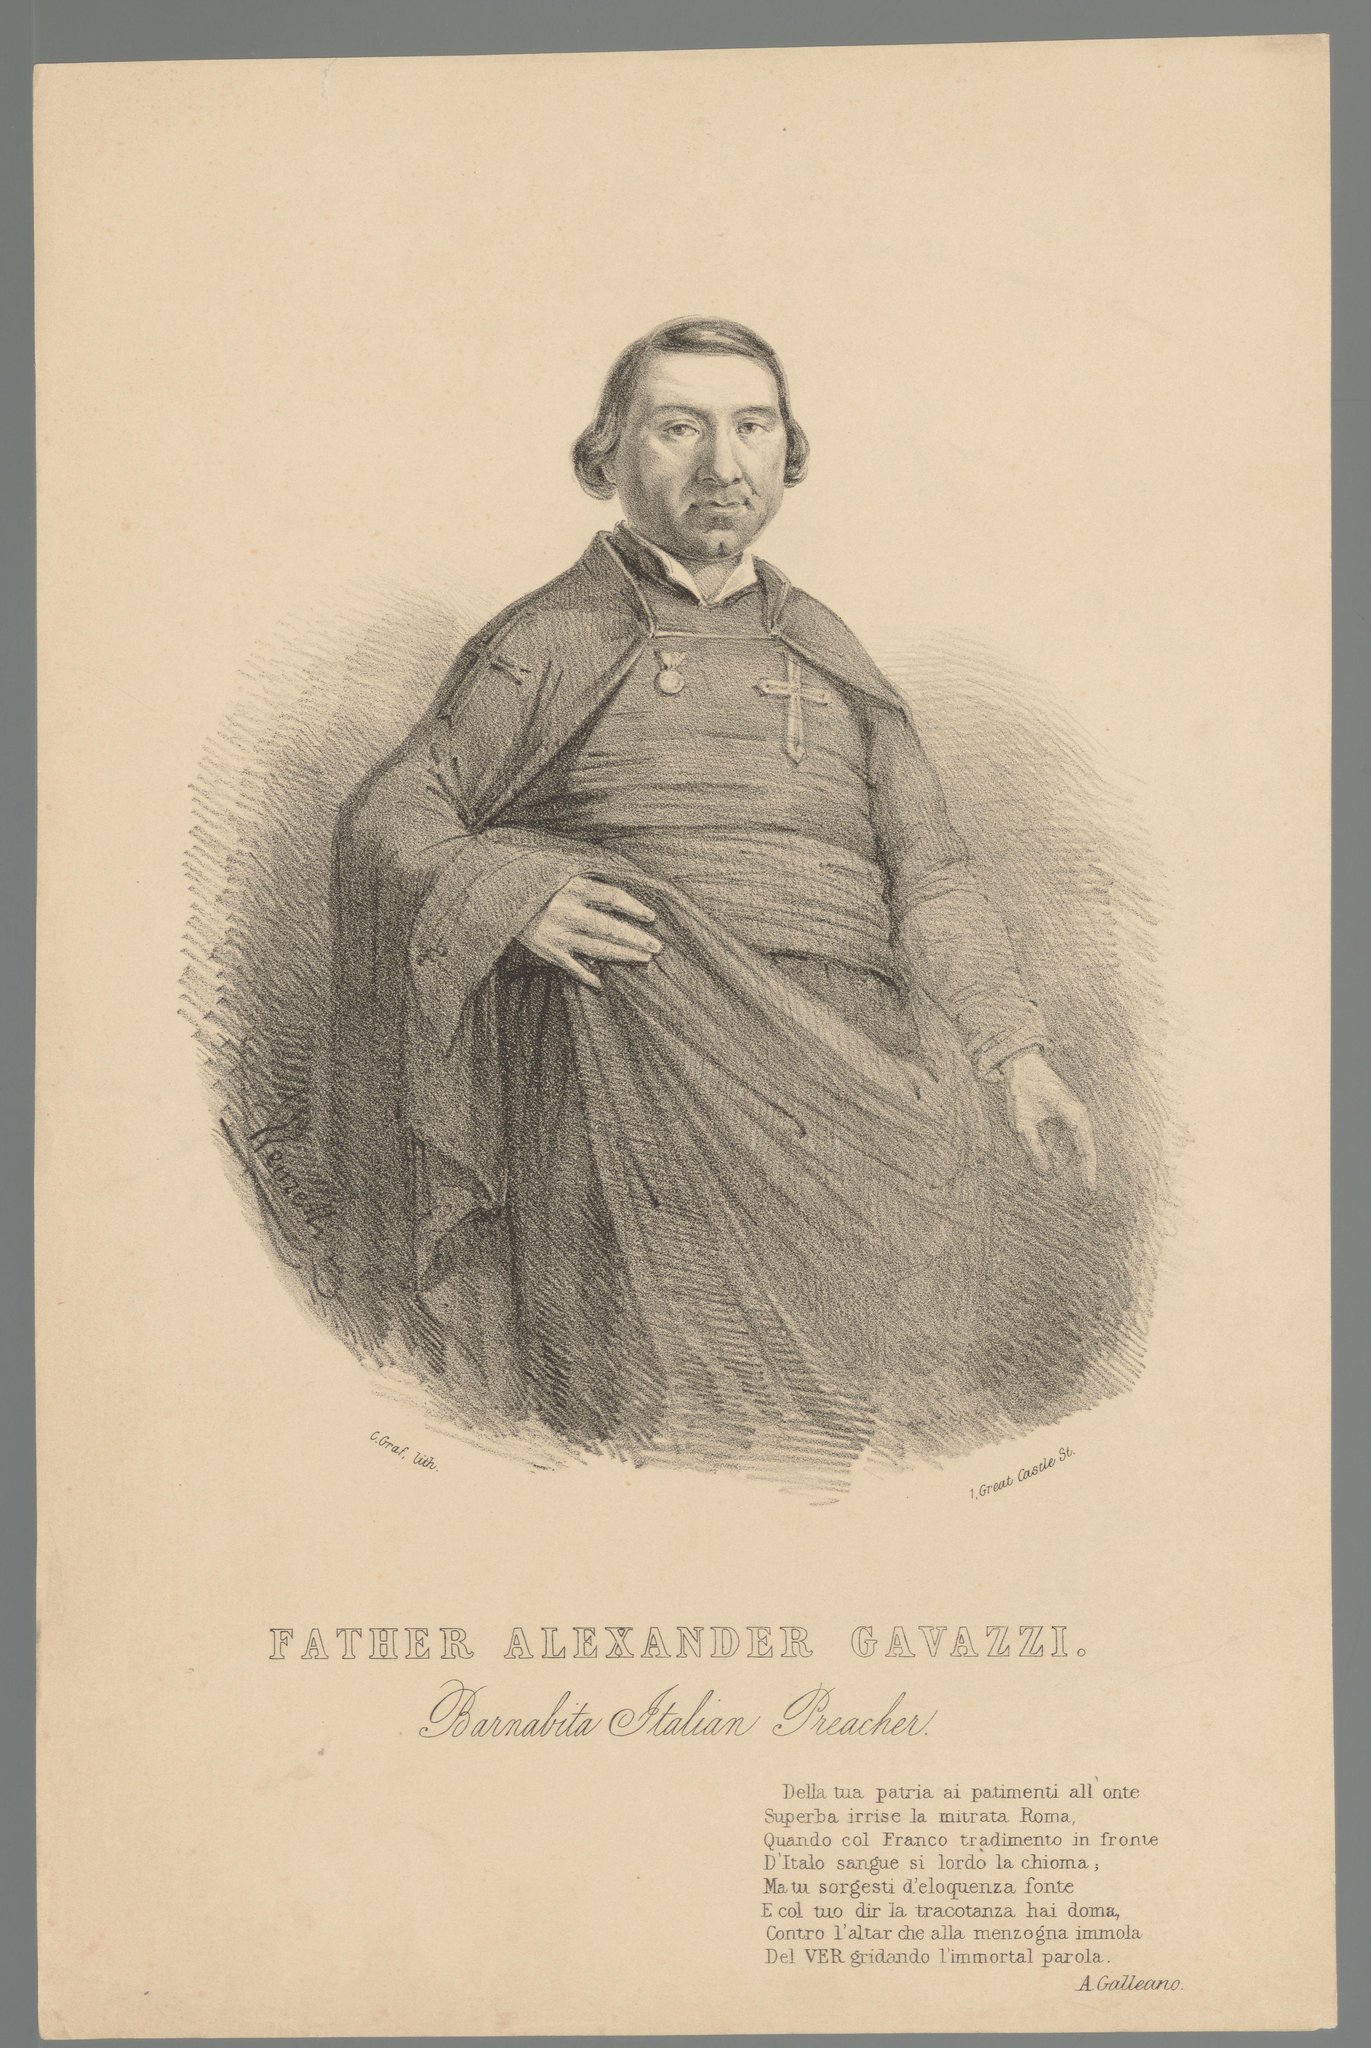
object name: print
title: Portret van Alessandro Gavazzi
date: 1835-1850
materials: paper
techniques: lithograph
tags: adult man, historical persons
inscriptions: collector's mark: Lugt 2228, mark: ‘[Wenzell]’